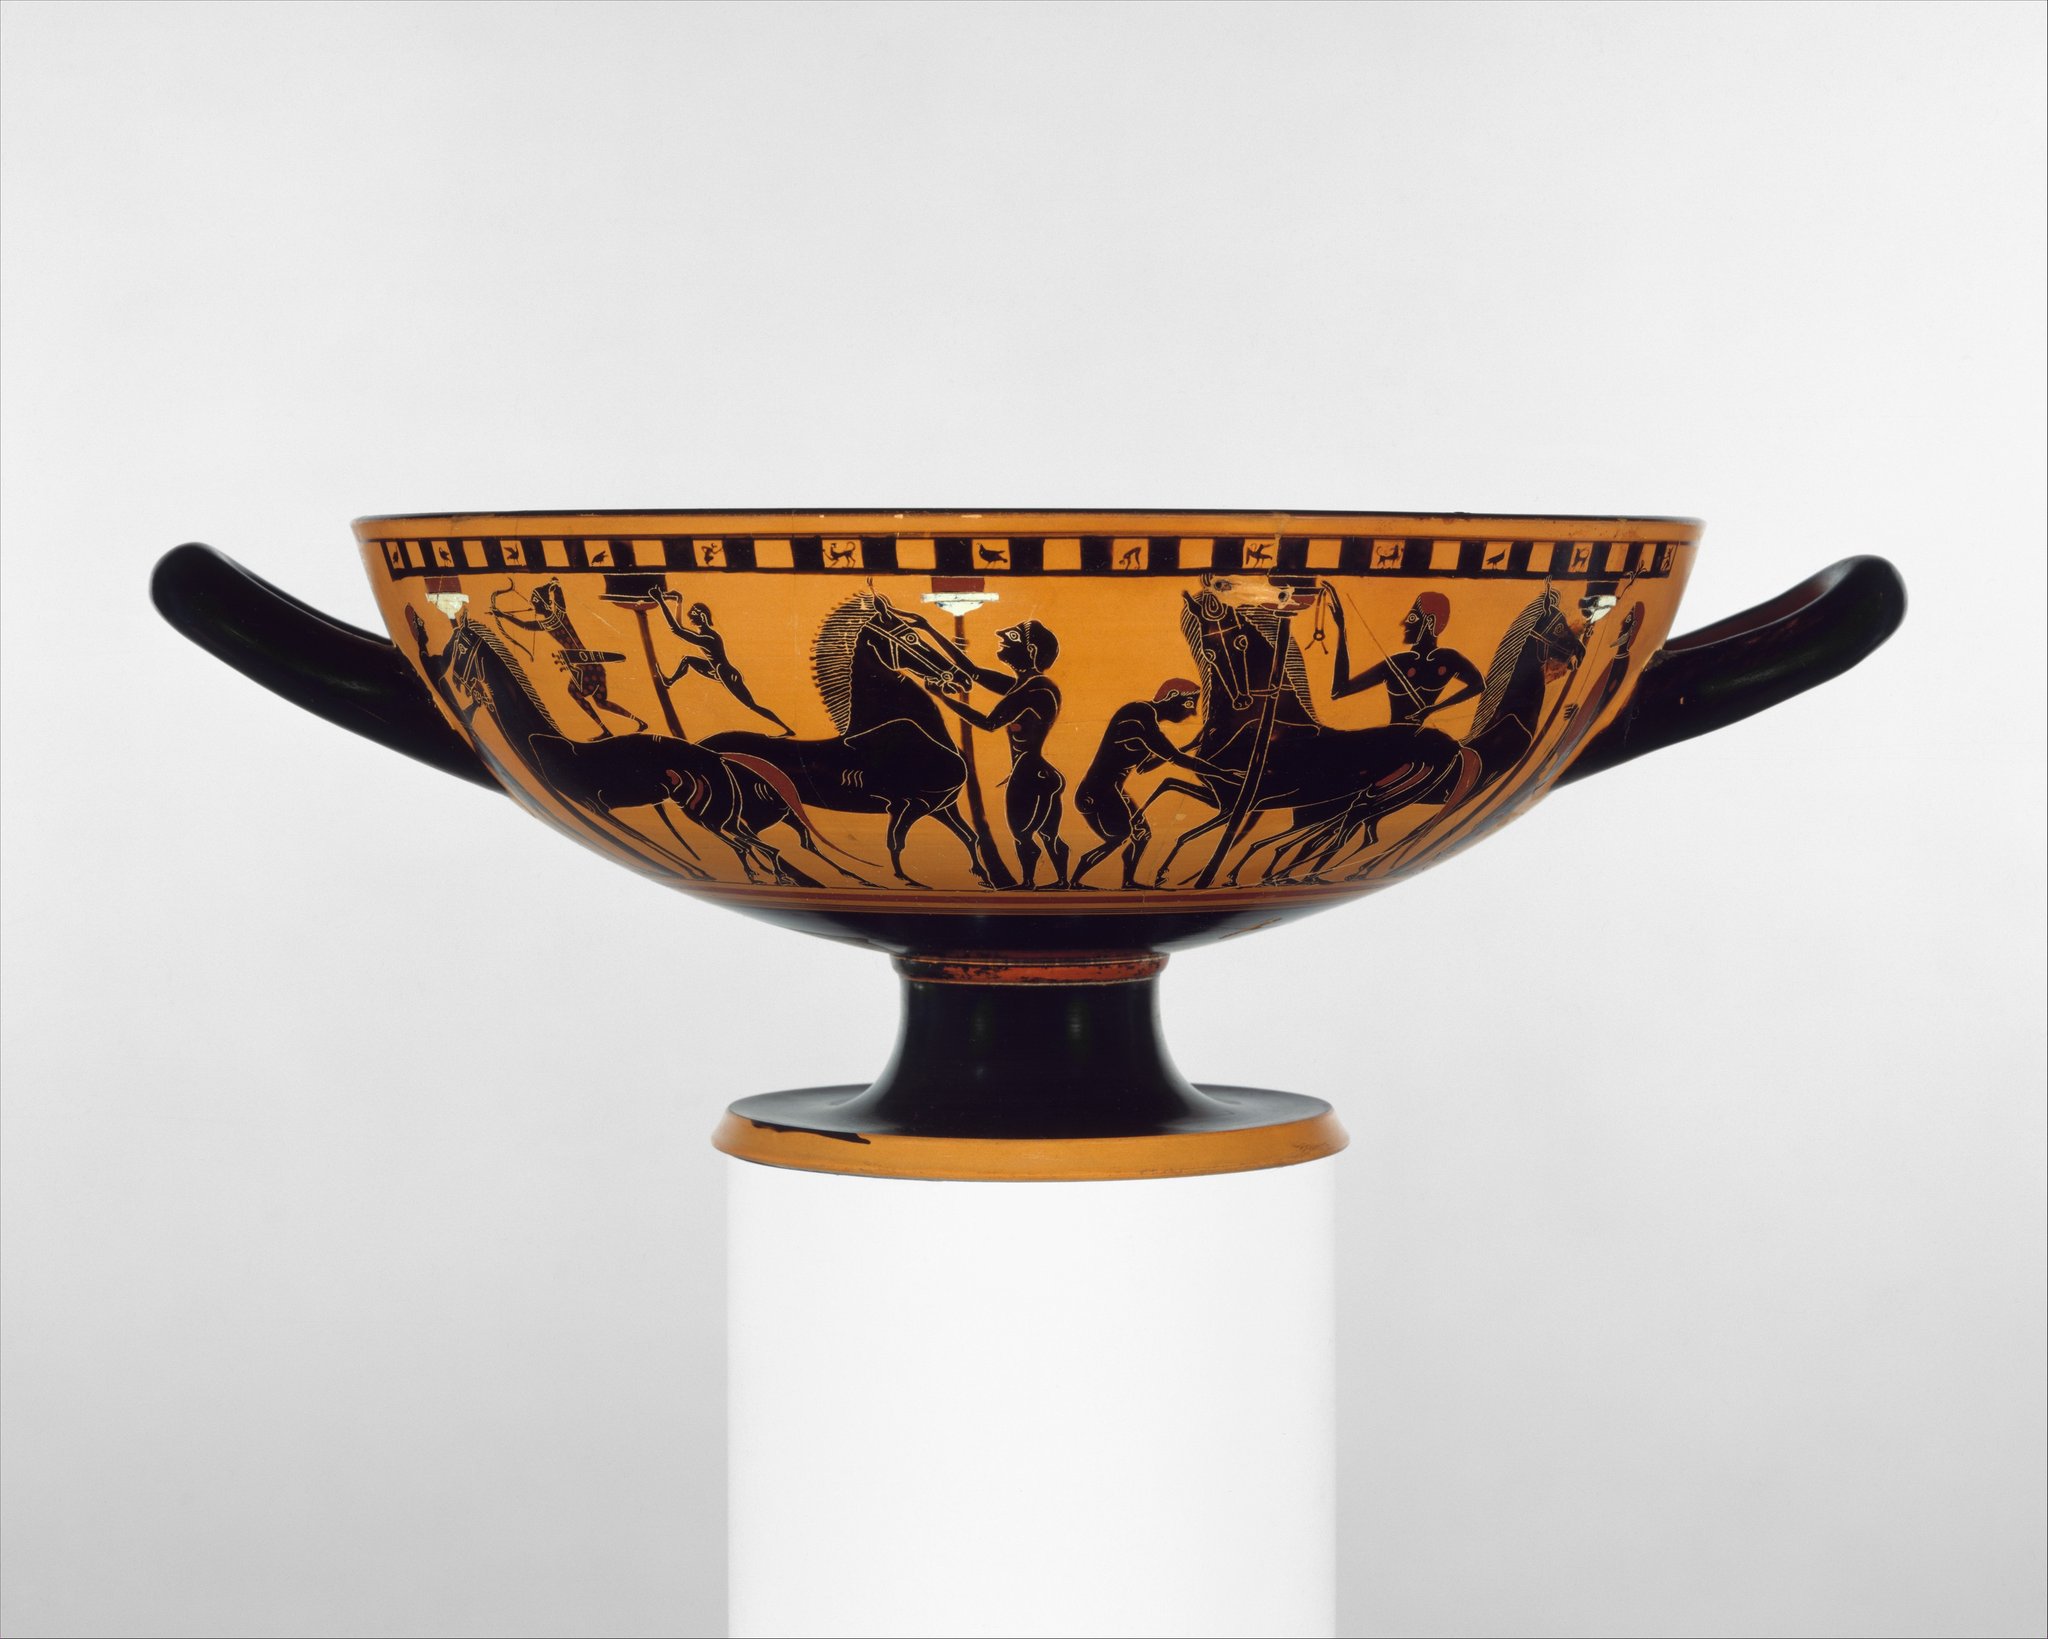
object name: kylix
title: Terracotta kylix (drinking cup)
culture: greek, attic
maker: amasis painter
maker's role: artist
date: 540 BCE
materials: terracotta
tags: male nudes,poseidon,horses,warriors,iliad